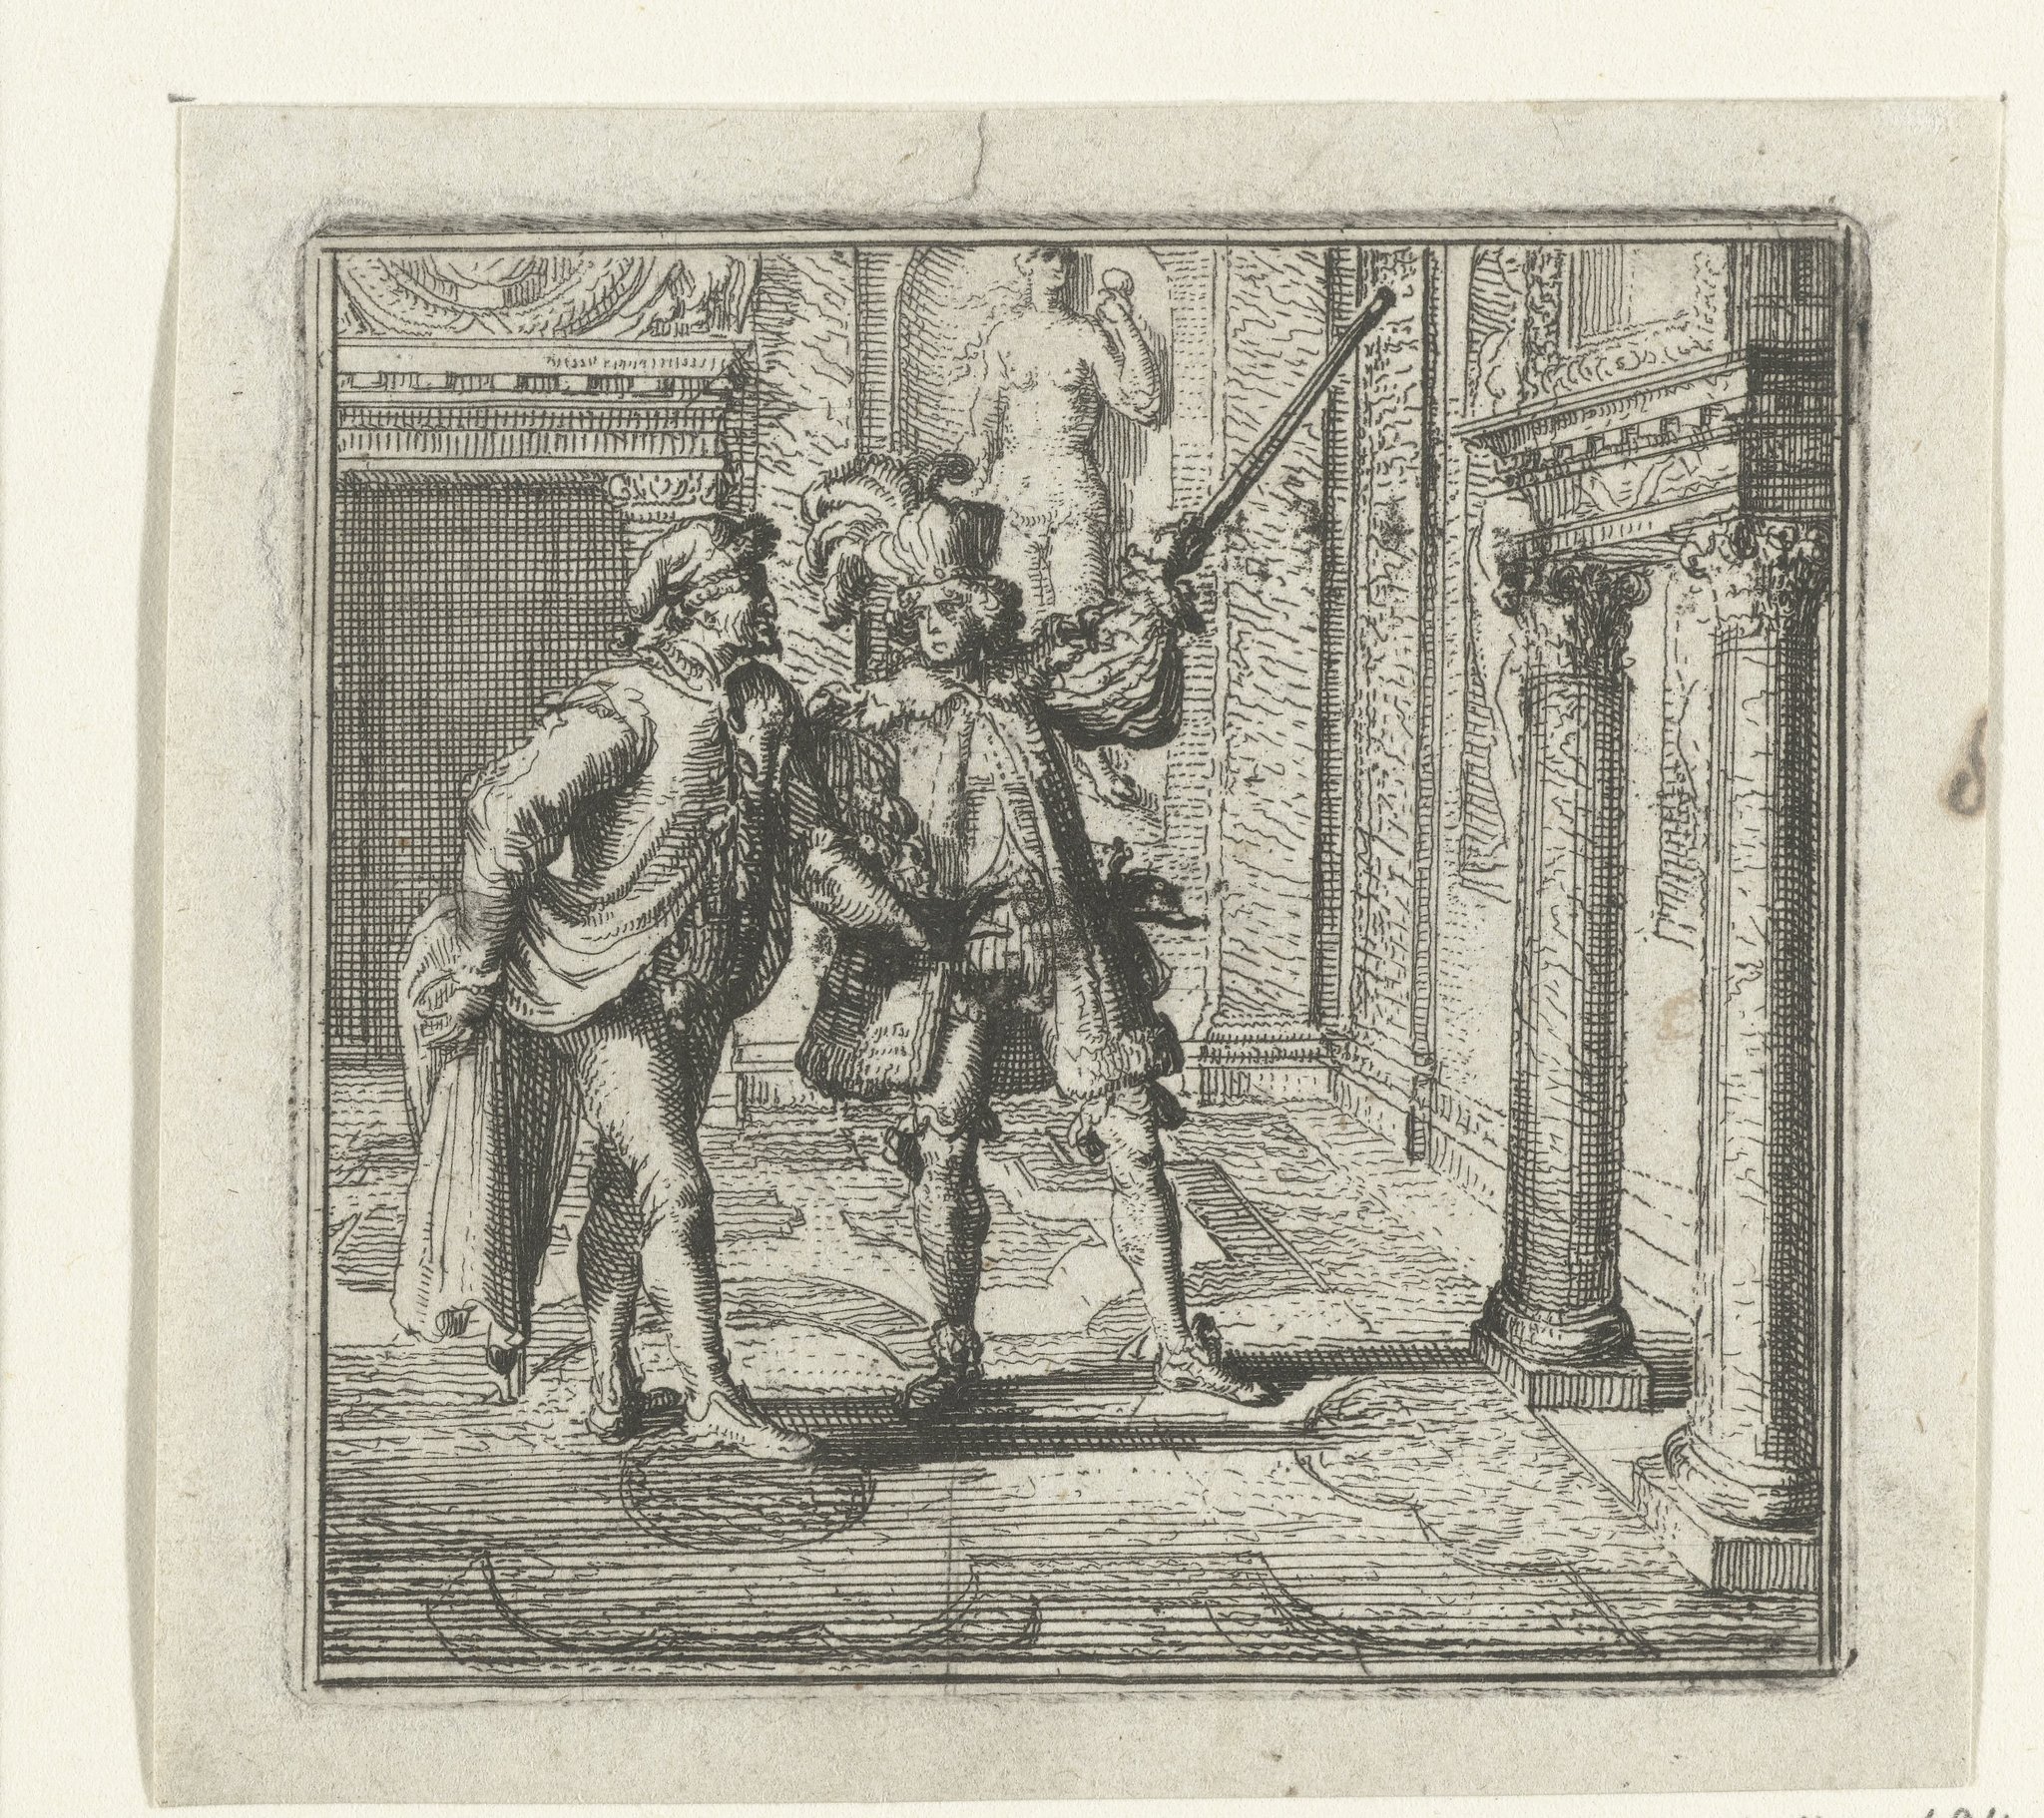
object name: print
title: Illustratie voor de Decamerone van Boccaccio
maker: romeyn de hooghe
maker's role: draughtsman, goldsmith, painter, print maker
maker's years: 1645-1708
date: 1697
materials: paper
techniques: etching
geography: netherlands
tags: (scenes from) specific works of literature: boccaccio, decamerone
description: Illustratie voor: Contes et nouvelles de Bocace Florentin. Traduction libre, 2 delen, Amsterdam, George Gallet, 1697. Latere edities met dezelfde illustraties uit 1699, 1702, 1732.